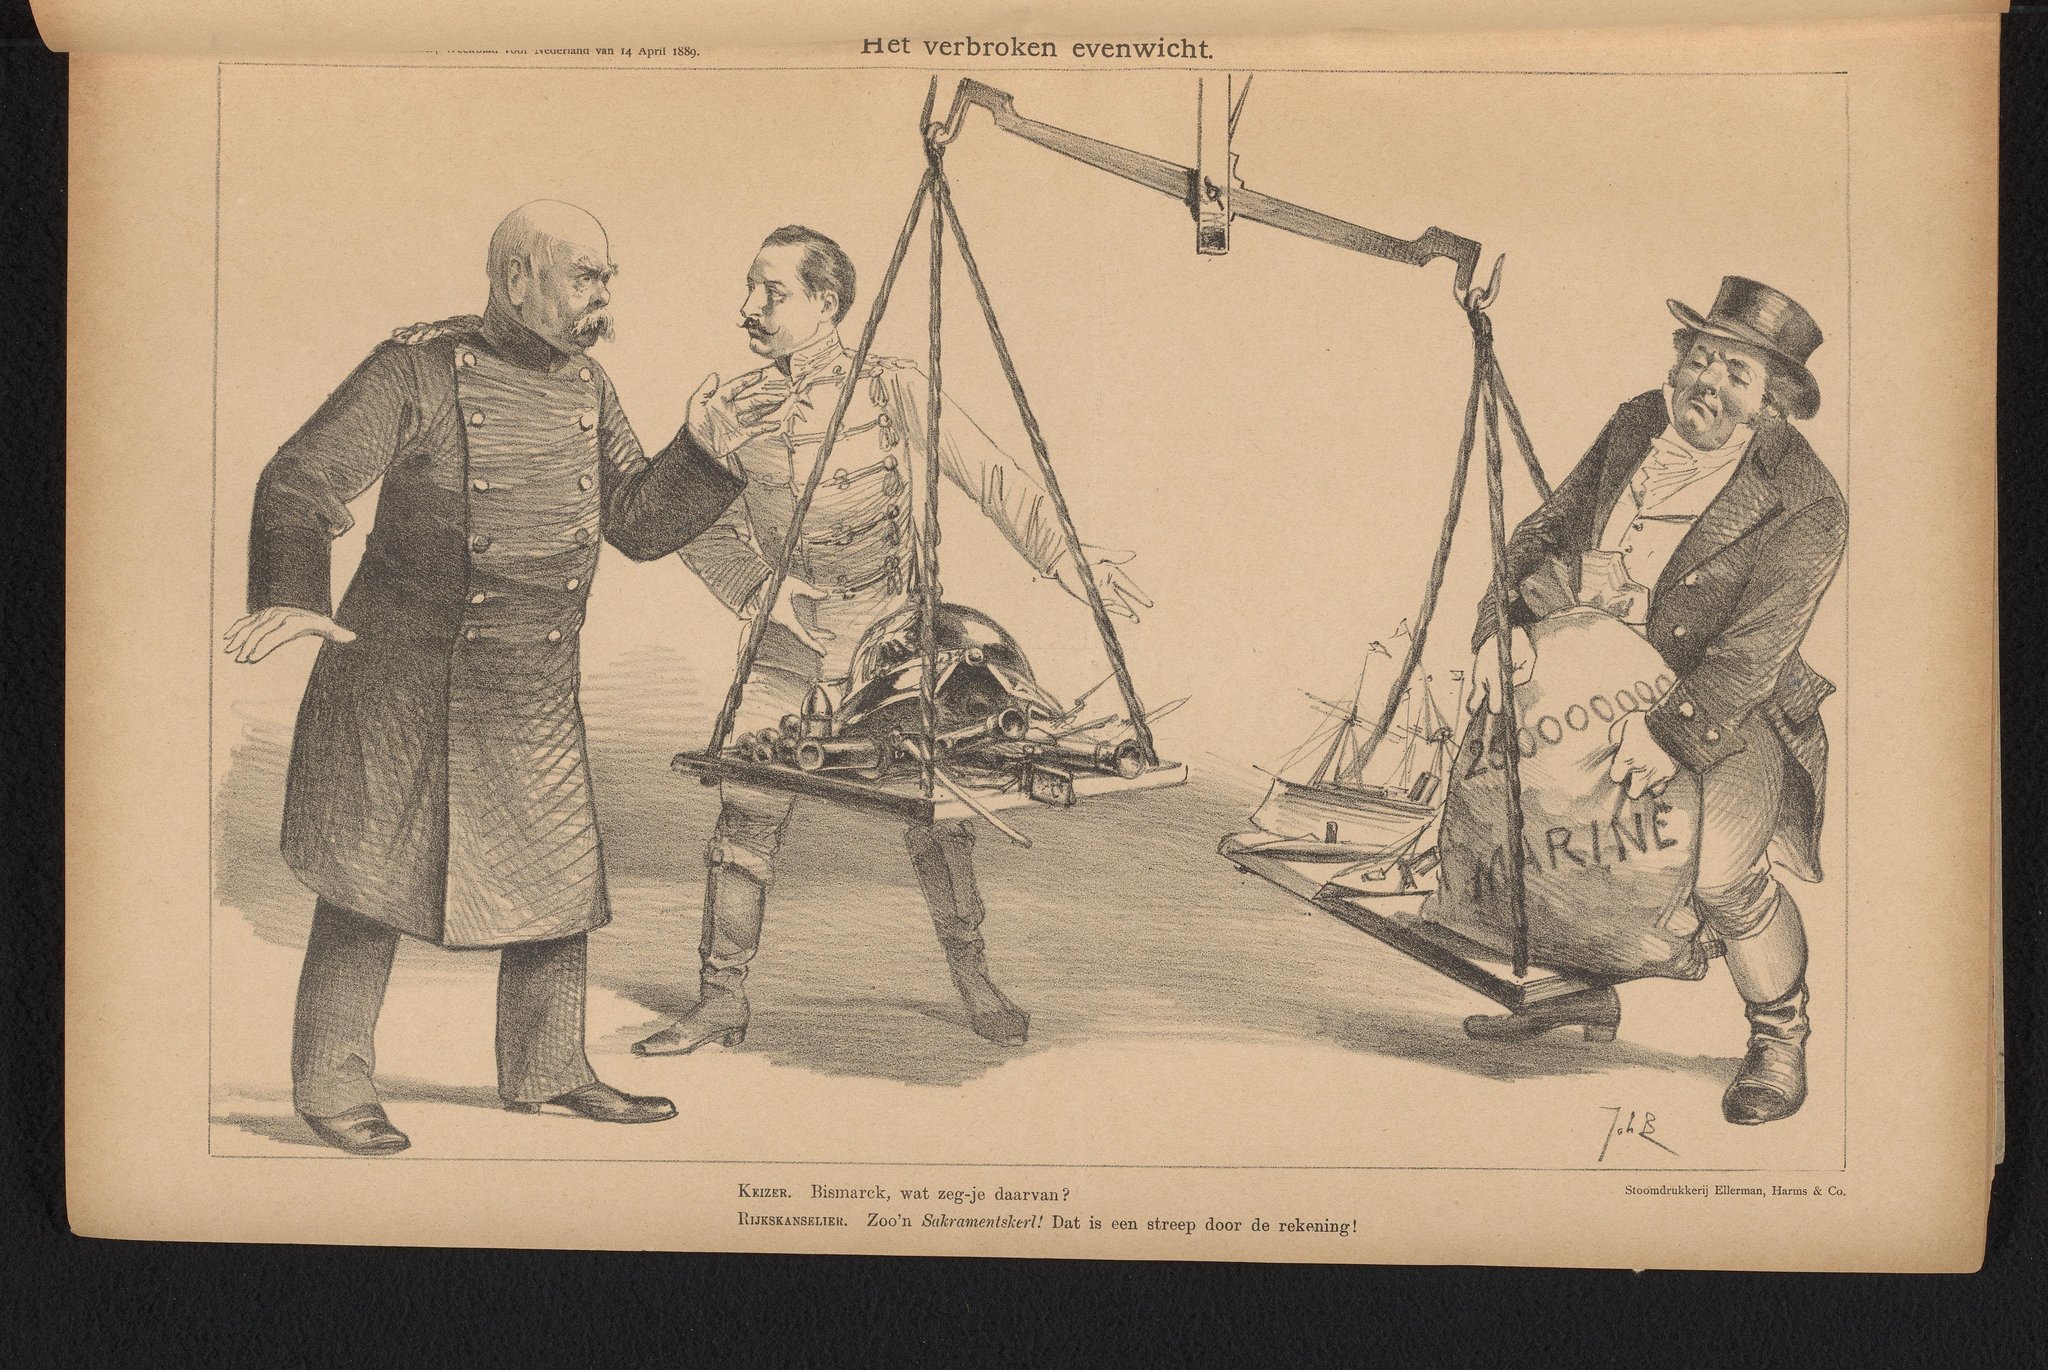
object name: cartoon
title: Het verbroken evenwicht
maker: johan braakensiek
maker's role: draughtsman, print maker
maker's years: 1858-1940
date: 1889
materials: paper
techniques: lithograph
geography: netherlands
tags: wilhelm ii (keizer van duitsland), scales, navy, personifications of countries, nations, states, districts, etc. (+ nation; national), political caricatures and satires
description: De Duitse keizer Wilhelm II en kanselier Bismarck zijn verbolgen als John Bull (Engeland) een grote zak met geld voor de Britse marine op de weegschaal zet.